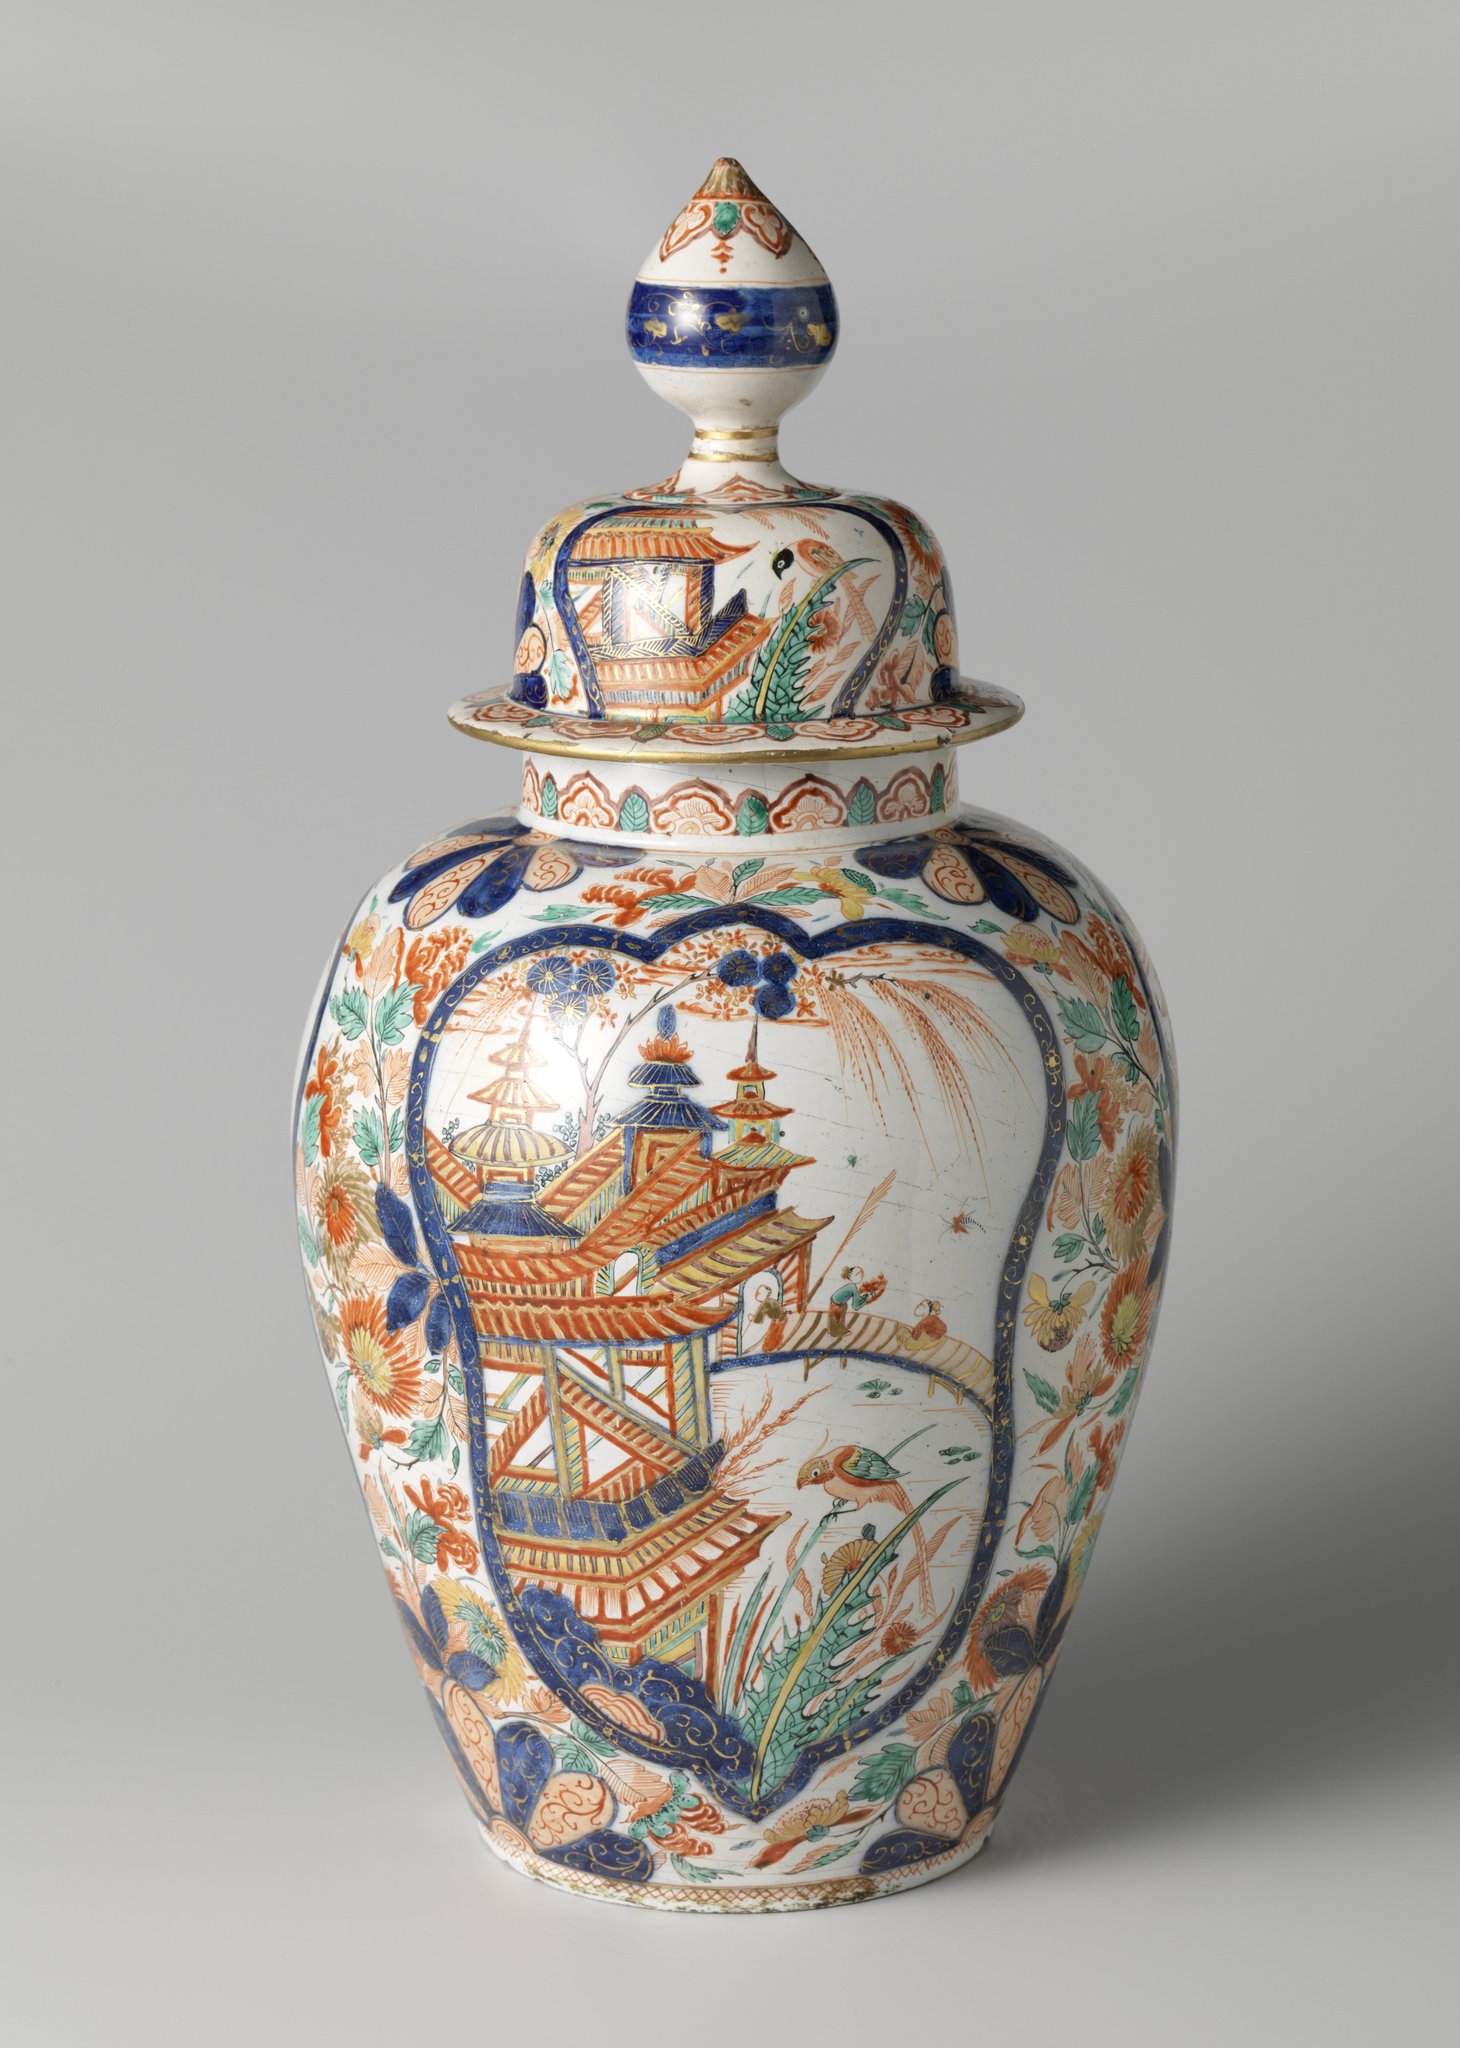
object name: covered jar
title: Deksel van veelkleurig beschilderde pot van faïence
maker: Anonymous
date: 1720-1740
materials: faience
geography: delft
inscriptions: mark: ‘513’, mark: ‘64’, collector's mark: ‘Collection J.F. Loudon’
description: Deksel van veelkleurig beschilderde pot van faïence